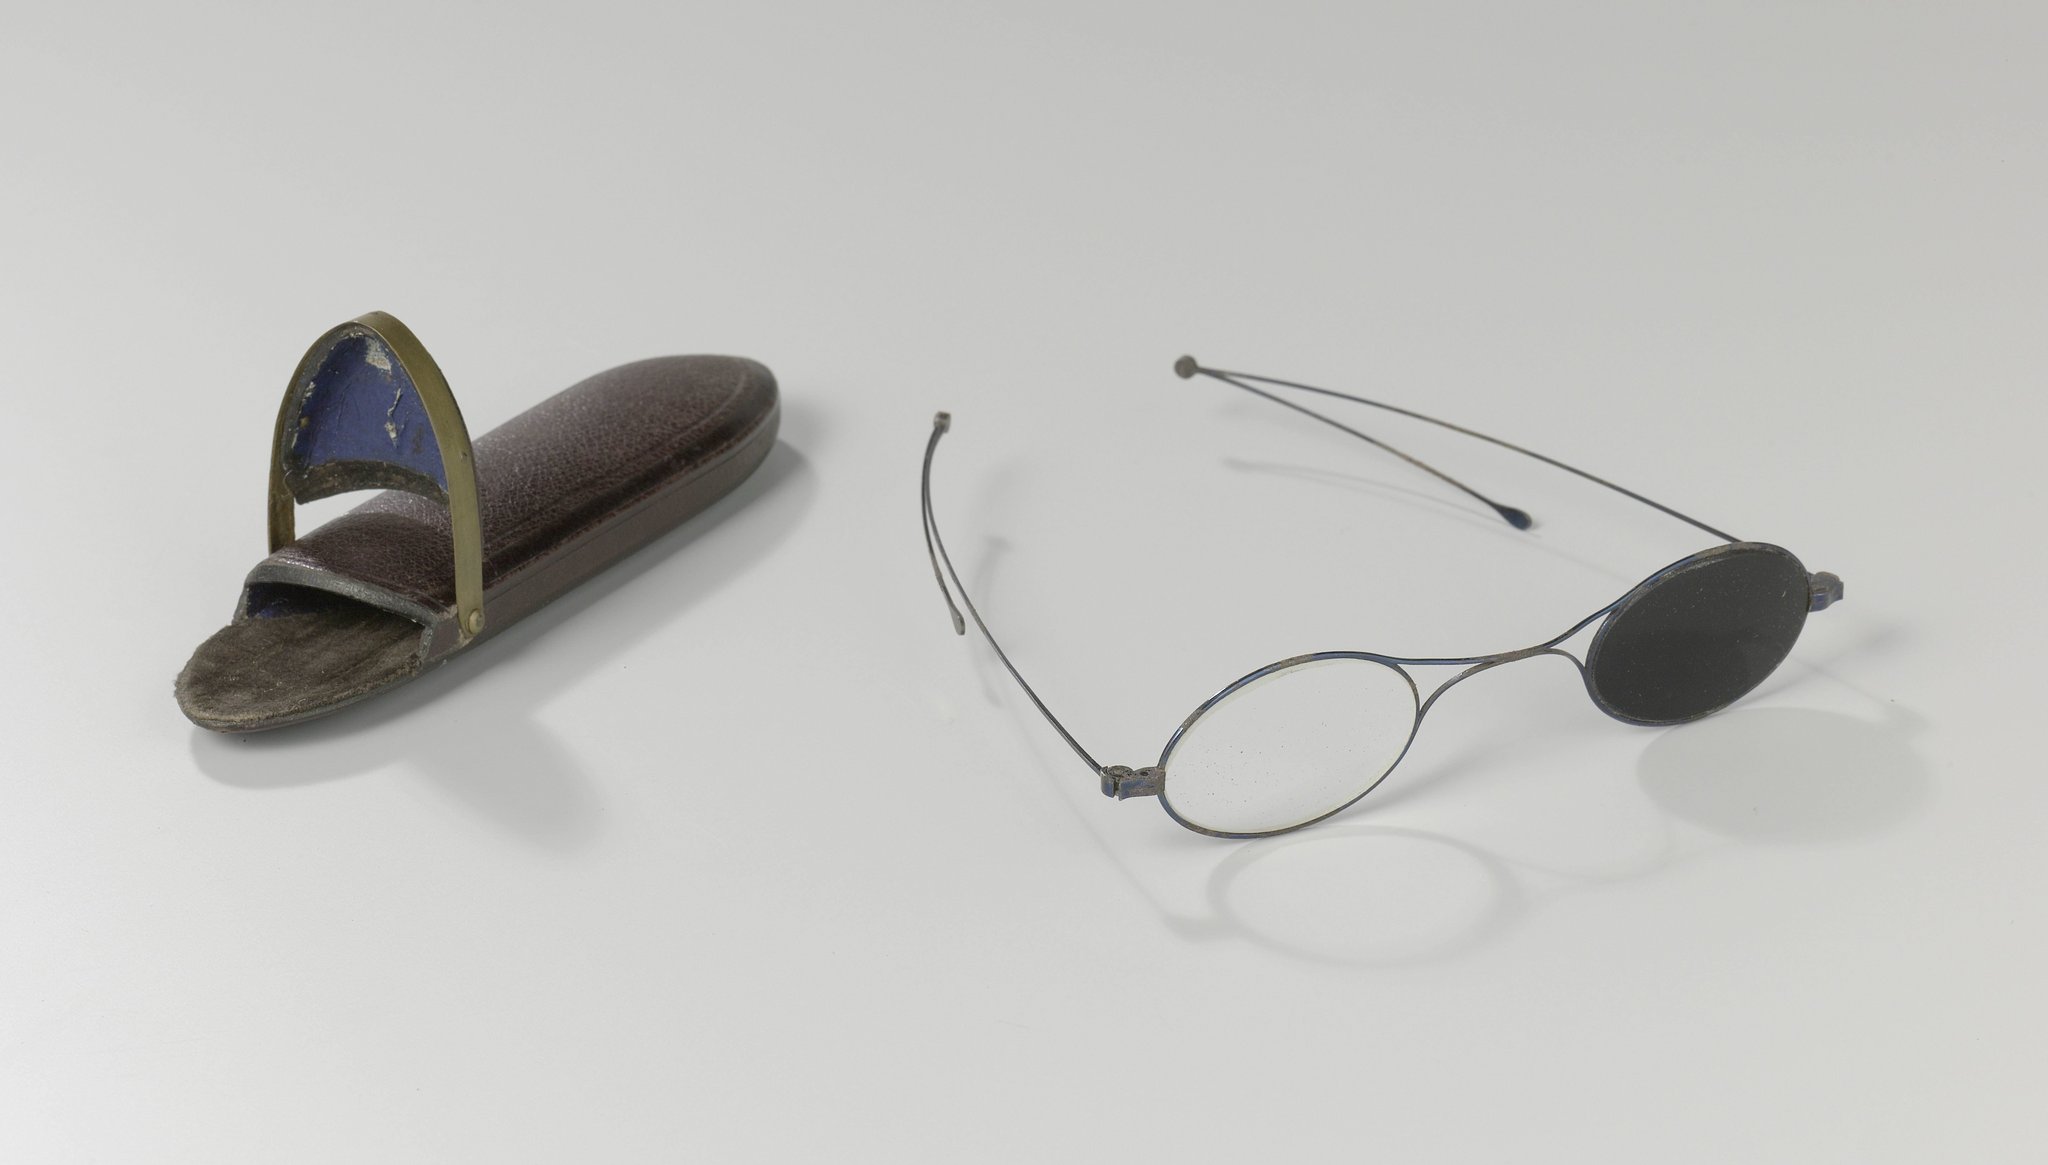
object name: brillendoos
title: Brillenkoker in ovaalvorm, buitenzijde beplakt met leer, aan een kant een opening met scharnierende klep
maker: Anonymous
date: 1830-1860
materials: copper, leather, velvet, wood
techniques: cutting, striking, weave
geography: amsterdam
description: In koker van hout (?), buitenzijde beplakt met bruin leer, binnenzijde met blauw fluweel. De opening heeft de vorm van een kaak van een slang, met een klepje, waarlangs een koperen bandje is gezet.